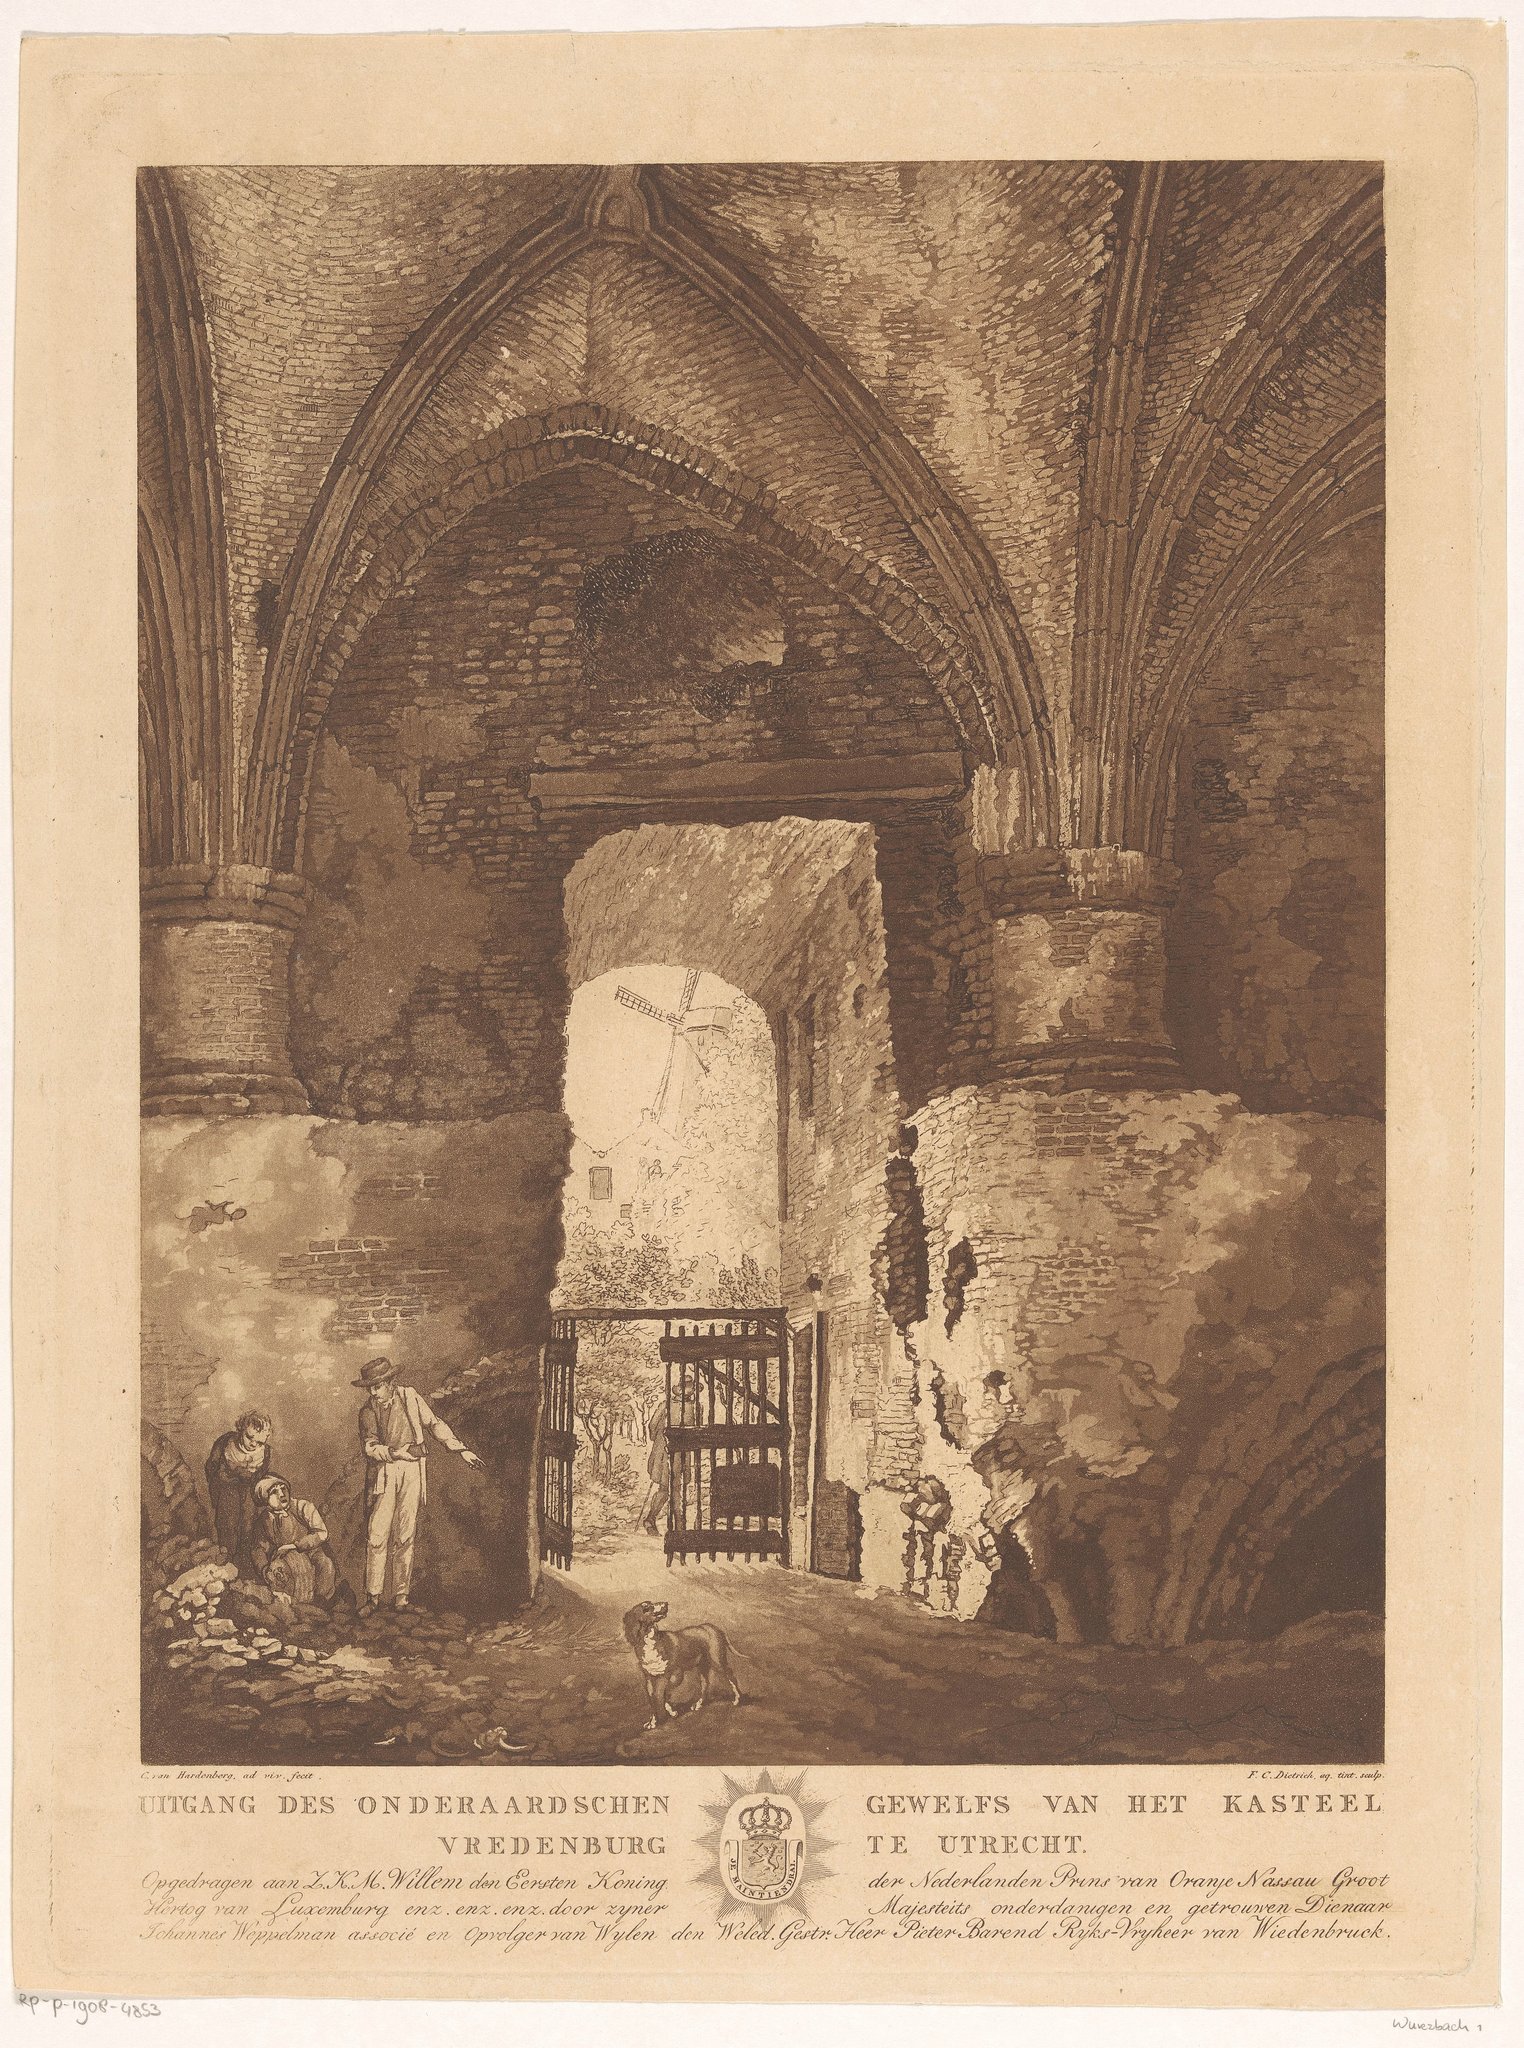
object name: print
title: Gezicht vanuit het onderaards gewelf van kasteel Vredenburg in Utrecht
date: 1789-1843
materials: paper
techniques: aquatint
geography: netherlands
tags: city-view, and landscape with man-made constructions, gate, entrance, vault ~ architecture, windmill, dog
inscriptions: collector's mark: Lugt 2228